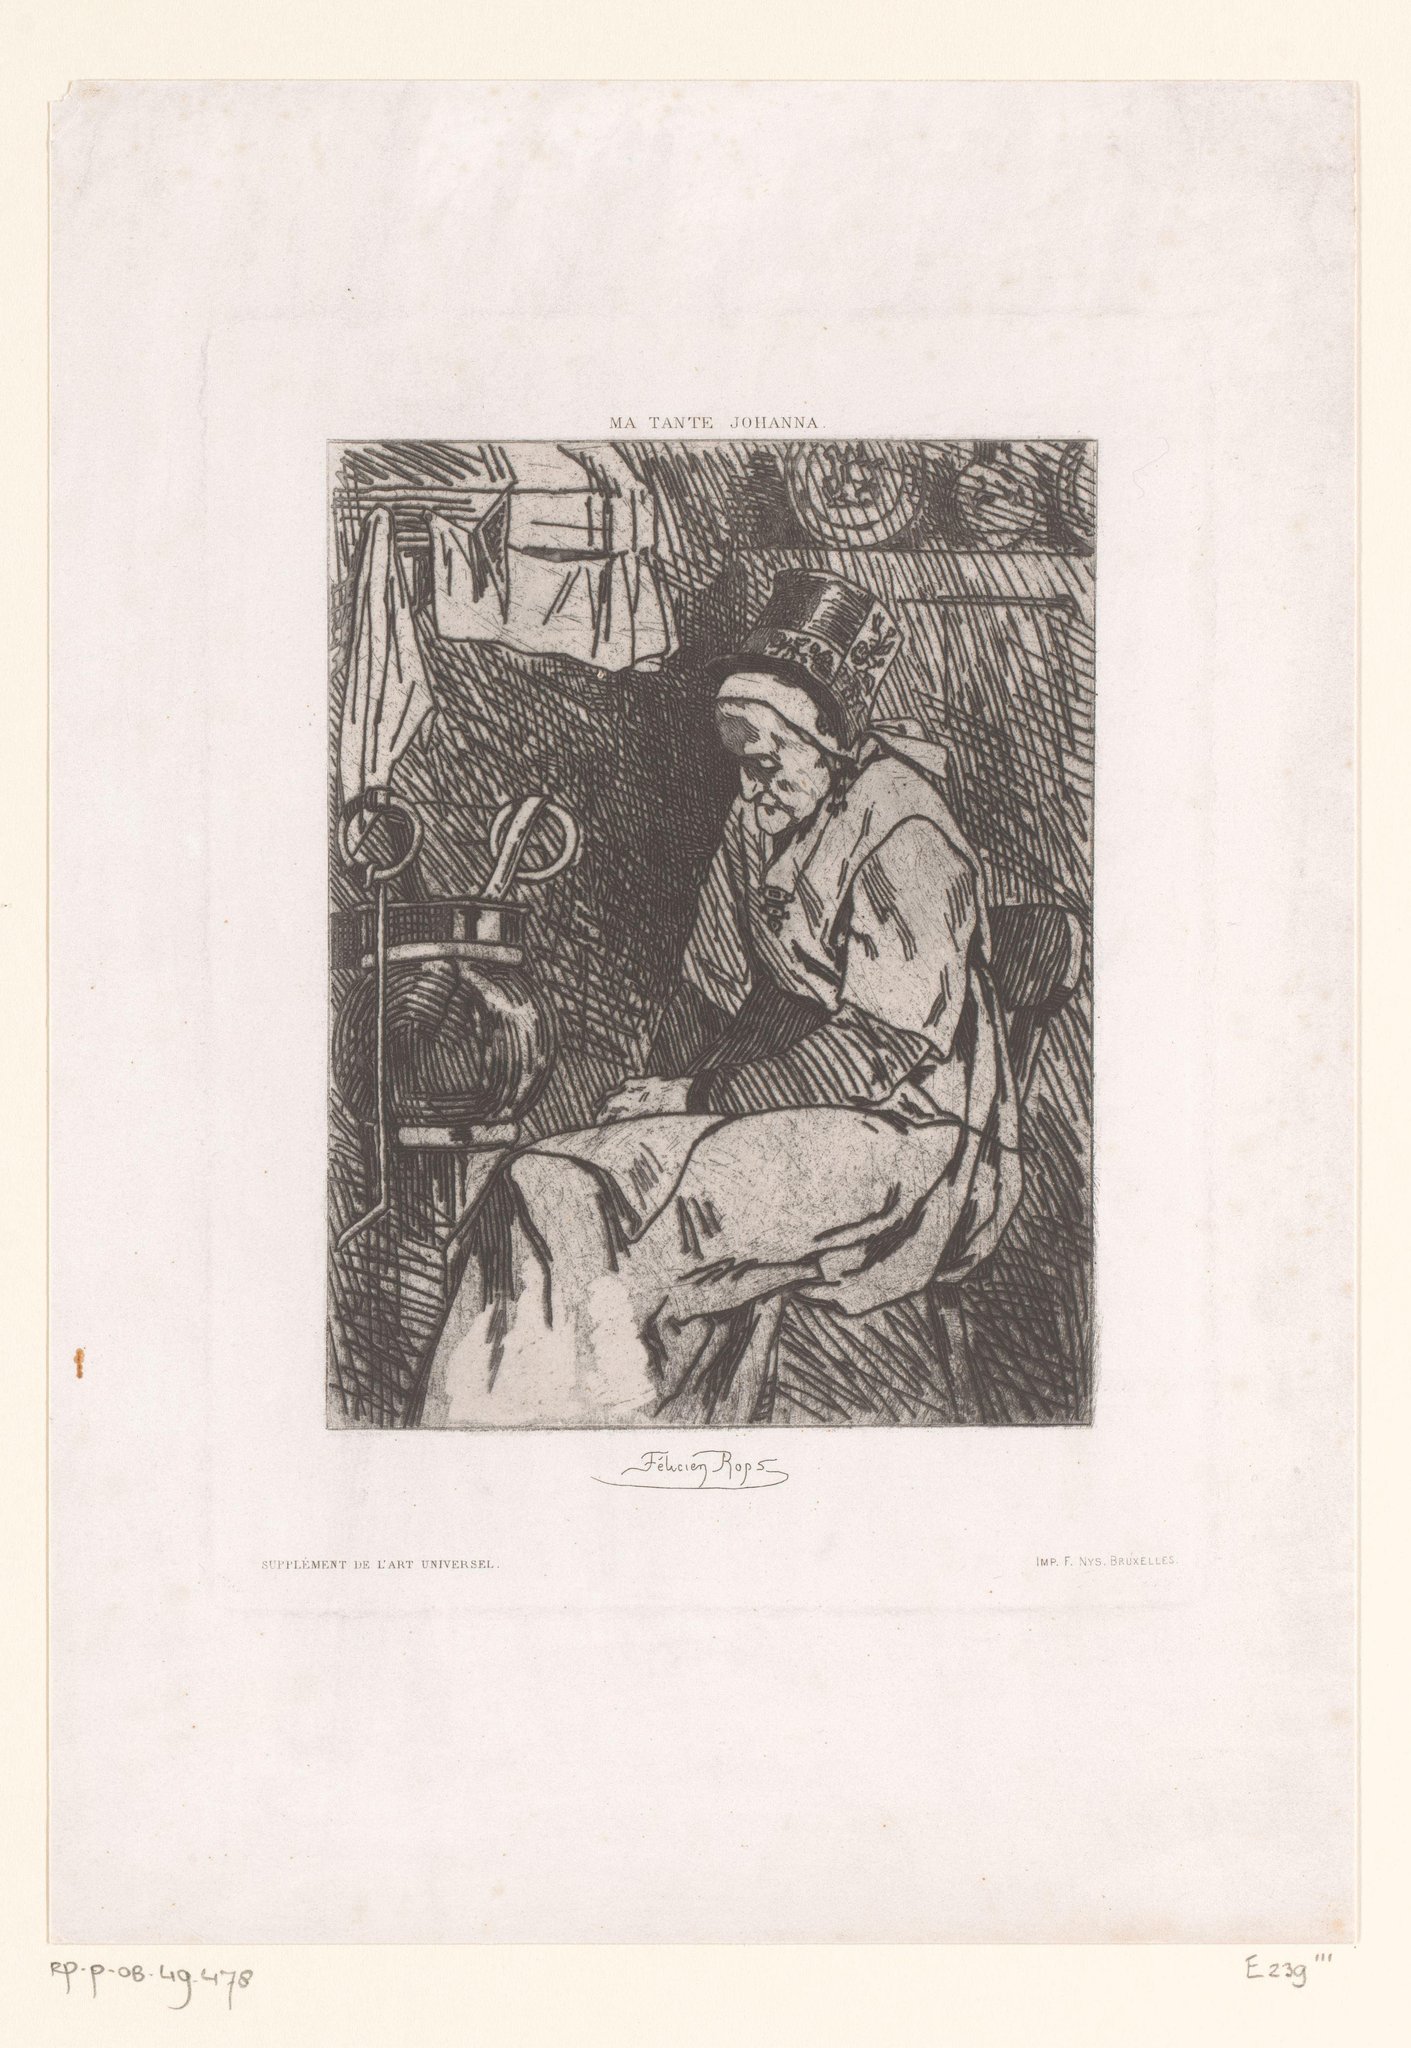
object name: print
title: Oude vrouw zittend in de keuken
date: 1874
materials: paper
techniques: aquatint, etching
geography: brussels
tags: old woman, kitchen-interior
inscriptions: collector's mark: Lugt 3073, collector's mark: Lugt 2228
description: Deze prent was een bijlage bij: L'Art universel, 1874.